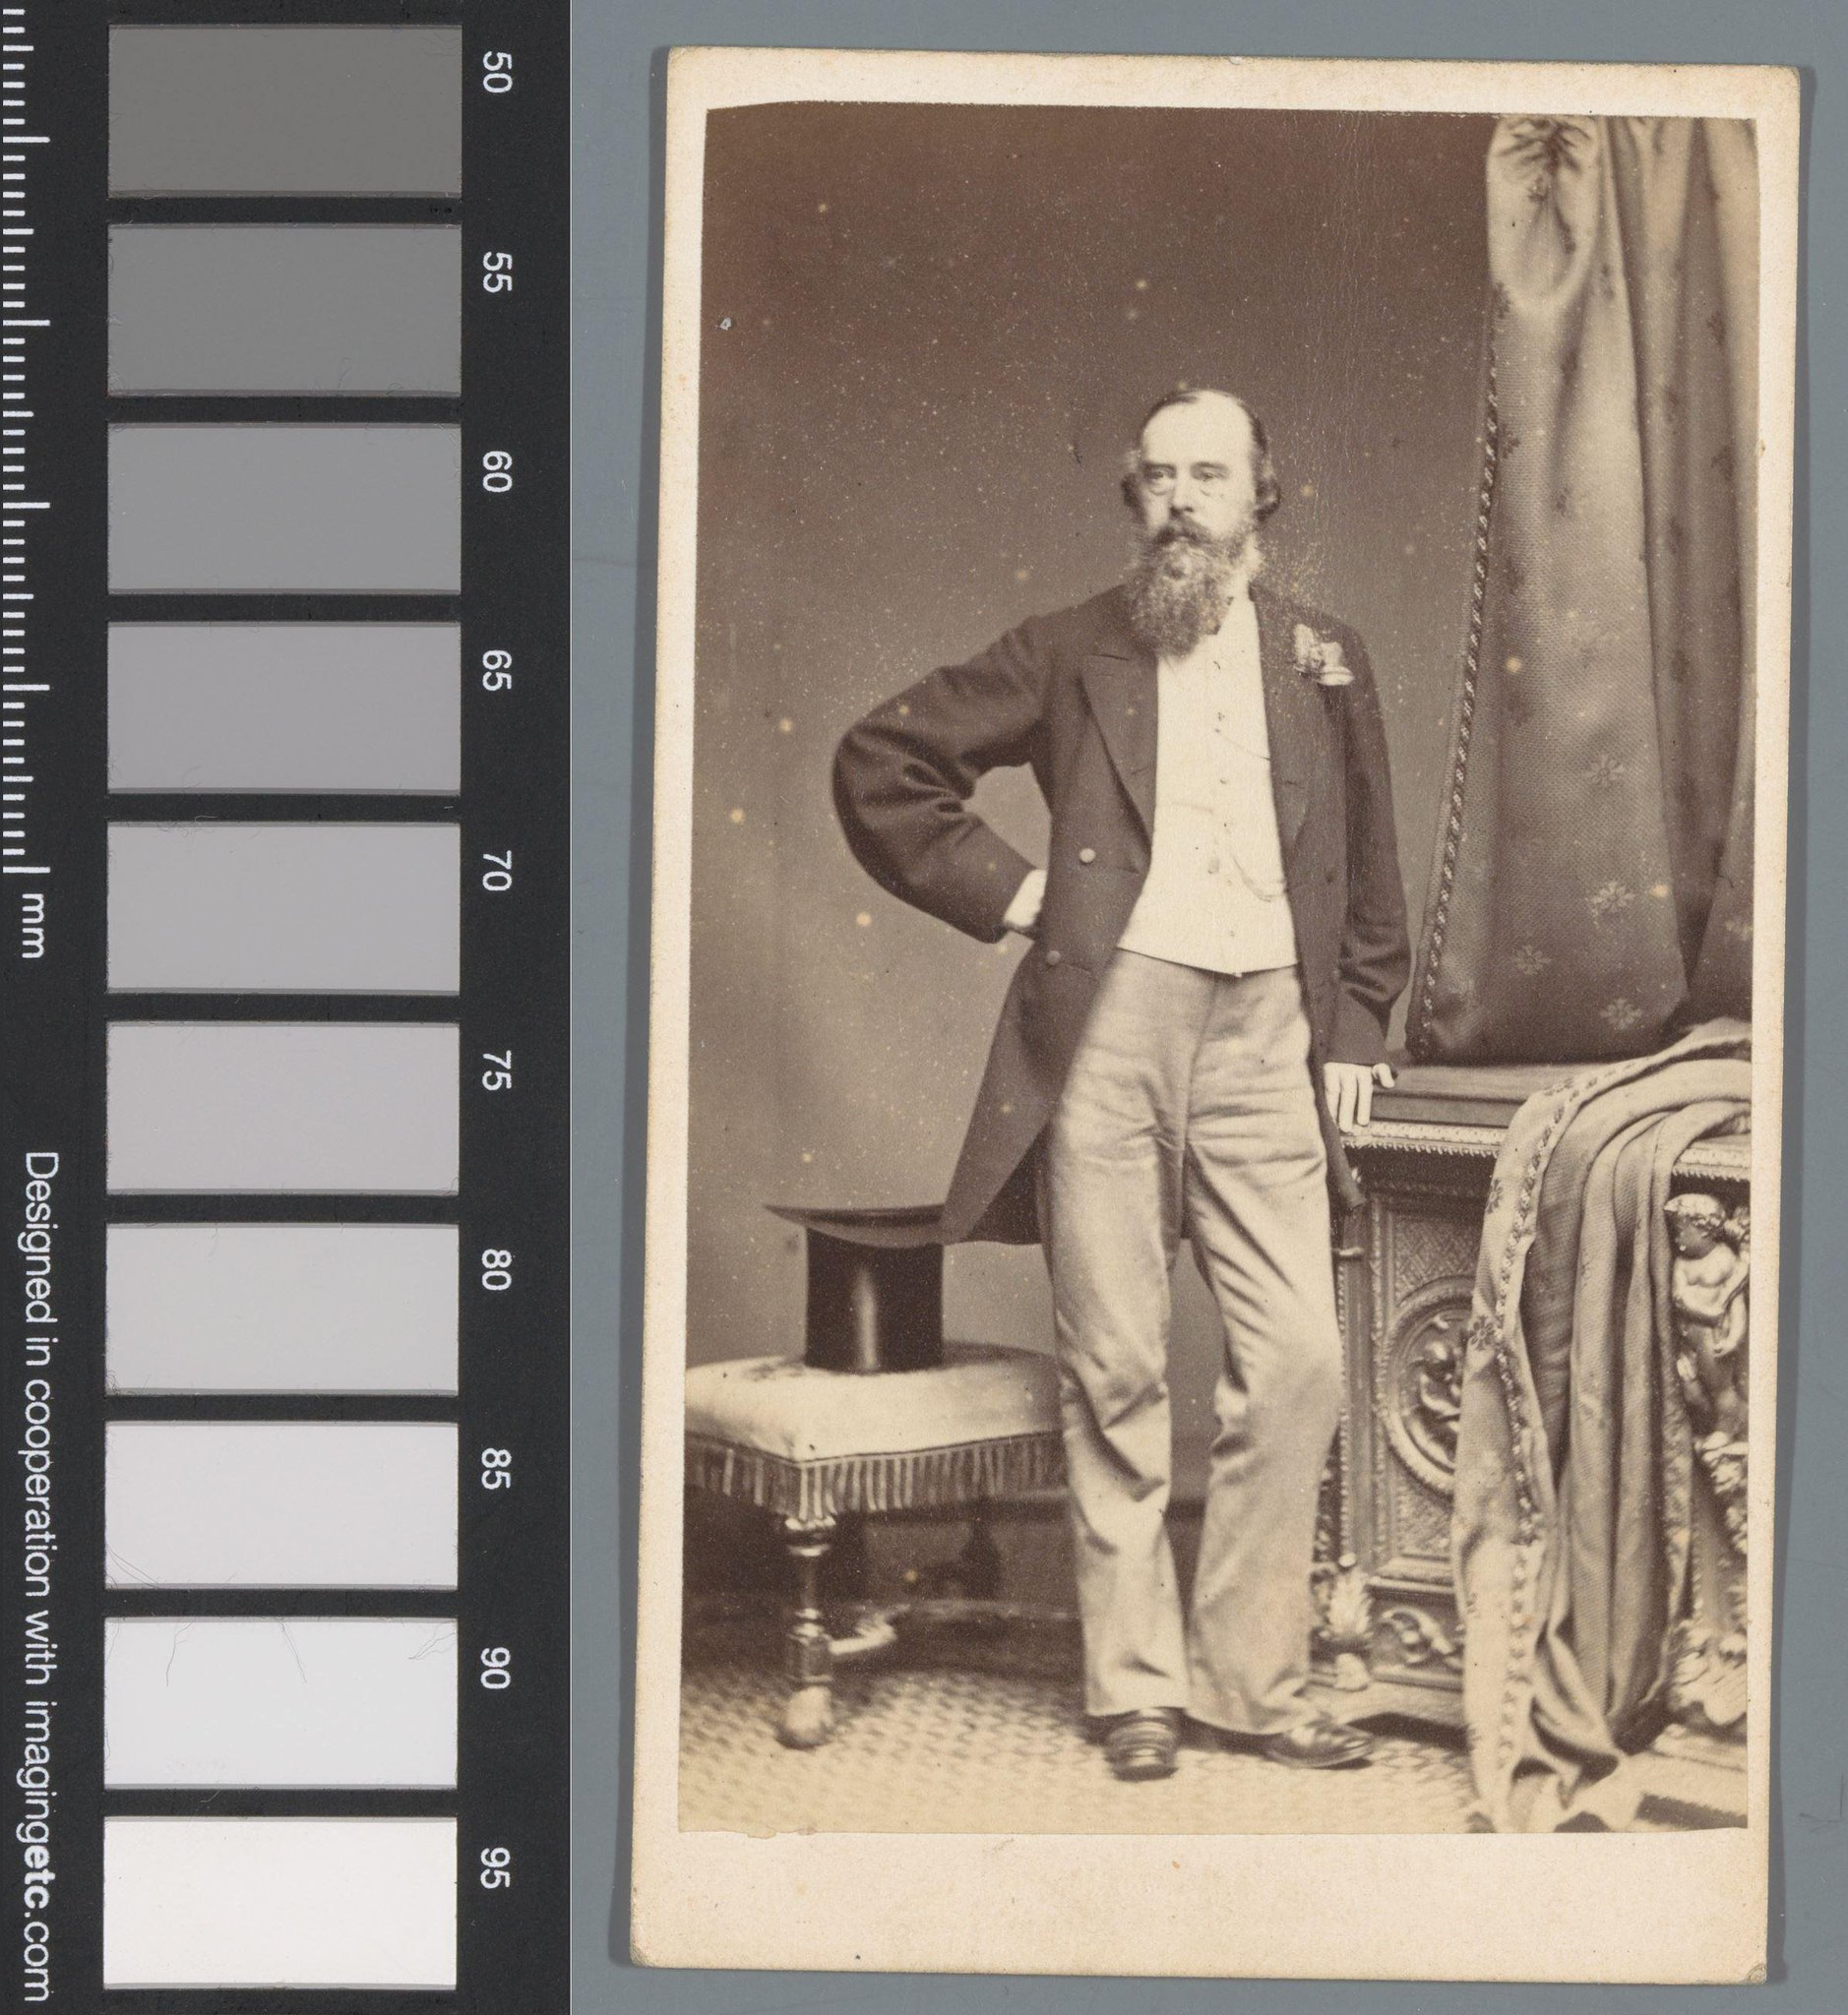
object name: carte de visite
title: Portret van een onbekende man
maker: Anonymous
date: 1855-1885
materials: cardboard, paper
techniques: albumen print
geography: sydenham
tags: adult man, historical persons, beard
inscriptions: number: ‘2716’, inscription: ‘TAKEN AT THE/ PHOTOGRAPHIC DEPARTMENT/ OF THE/ CRYSTAL PALACE/ SYDENHAM./ Negatives Kept copies/ can be obtained.’, inscription: ‘No.’